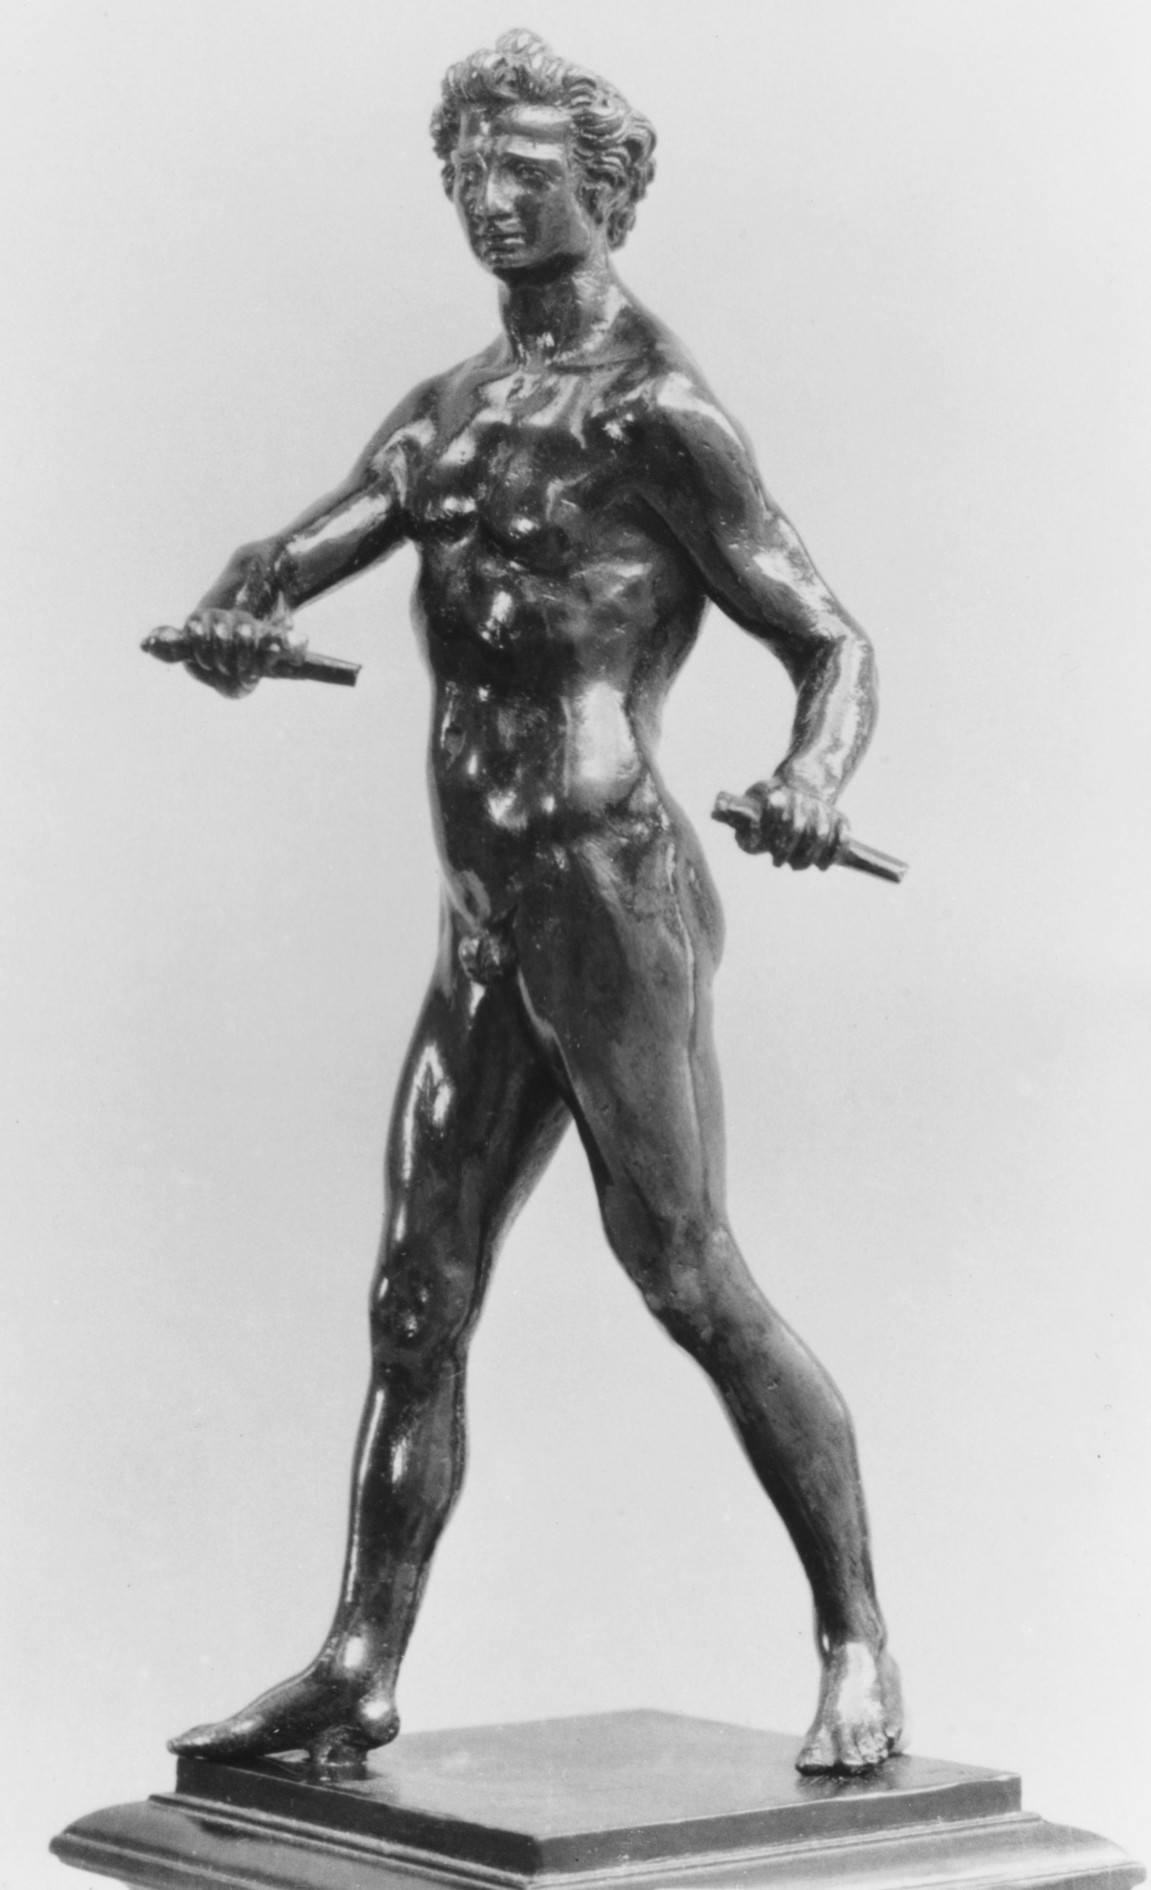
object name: statuette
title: Man Drawing a Sword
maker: barthélemy prieur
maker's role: artist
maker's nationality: french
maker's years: 1536-1611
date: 1601-1633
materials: bronze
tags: male nudes